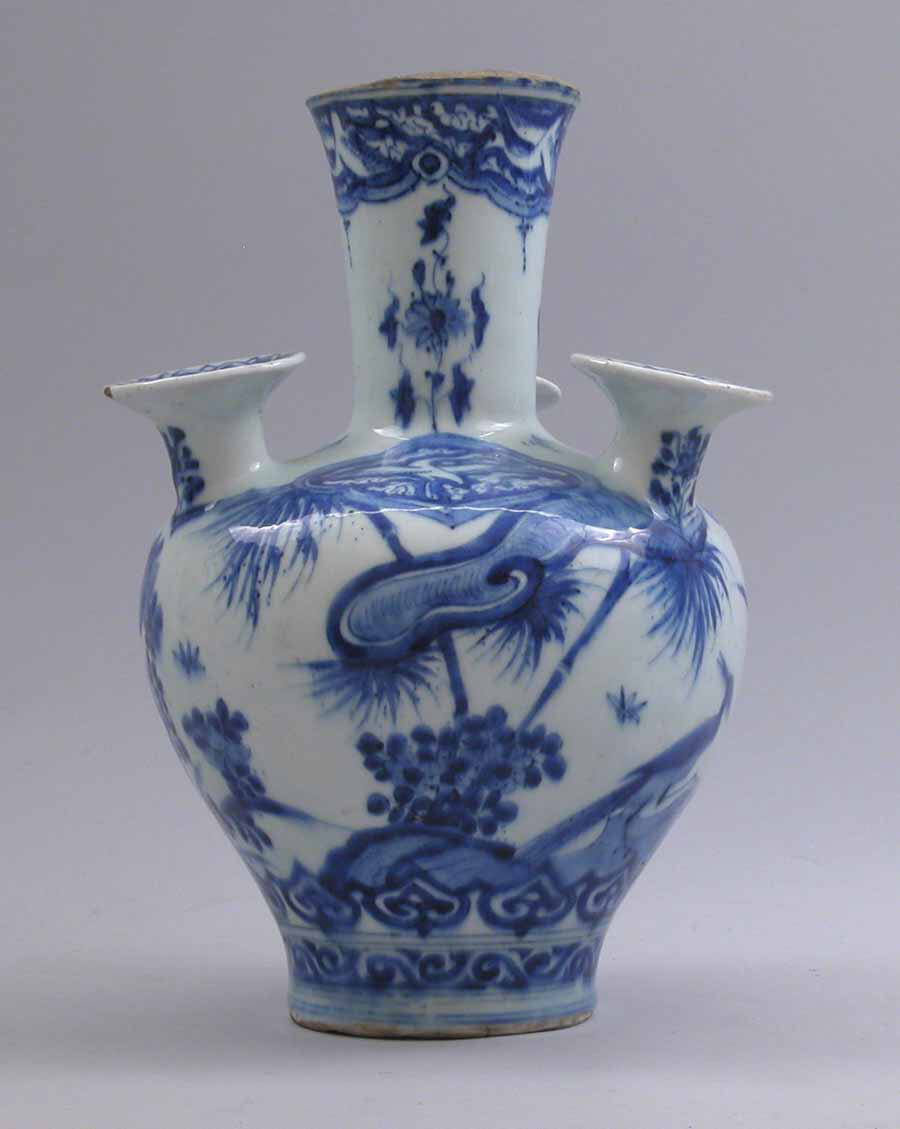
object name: vase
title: Tulip Vase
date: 1601-1700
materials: glaze, stonepaste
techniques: painting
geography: iran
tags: tulips